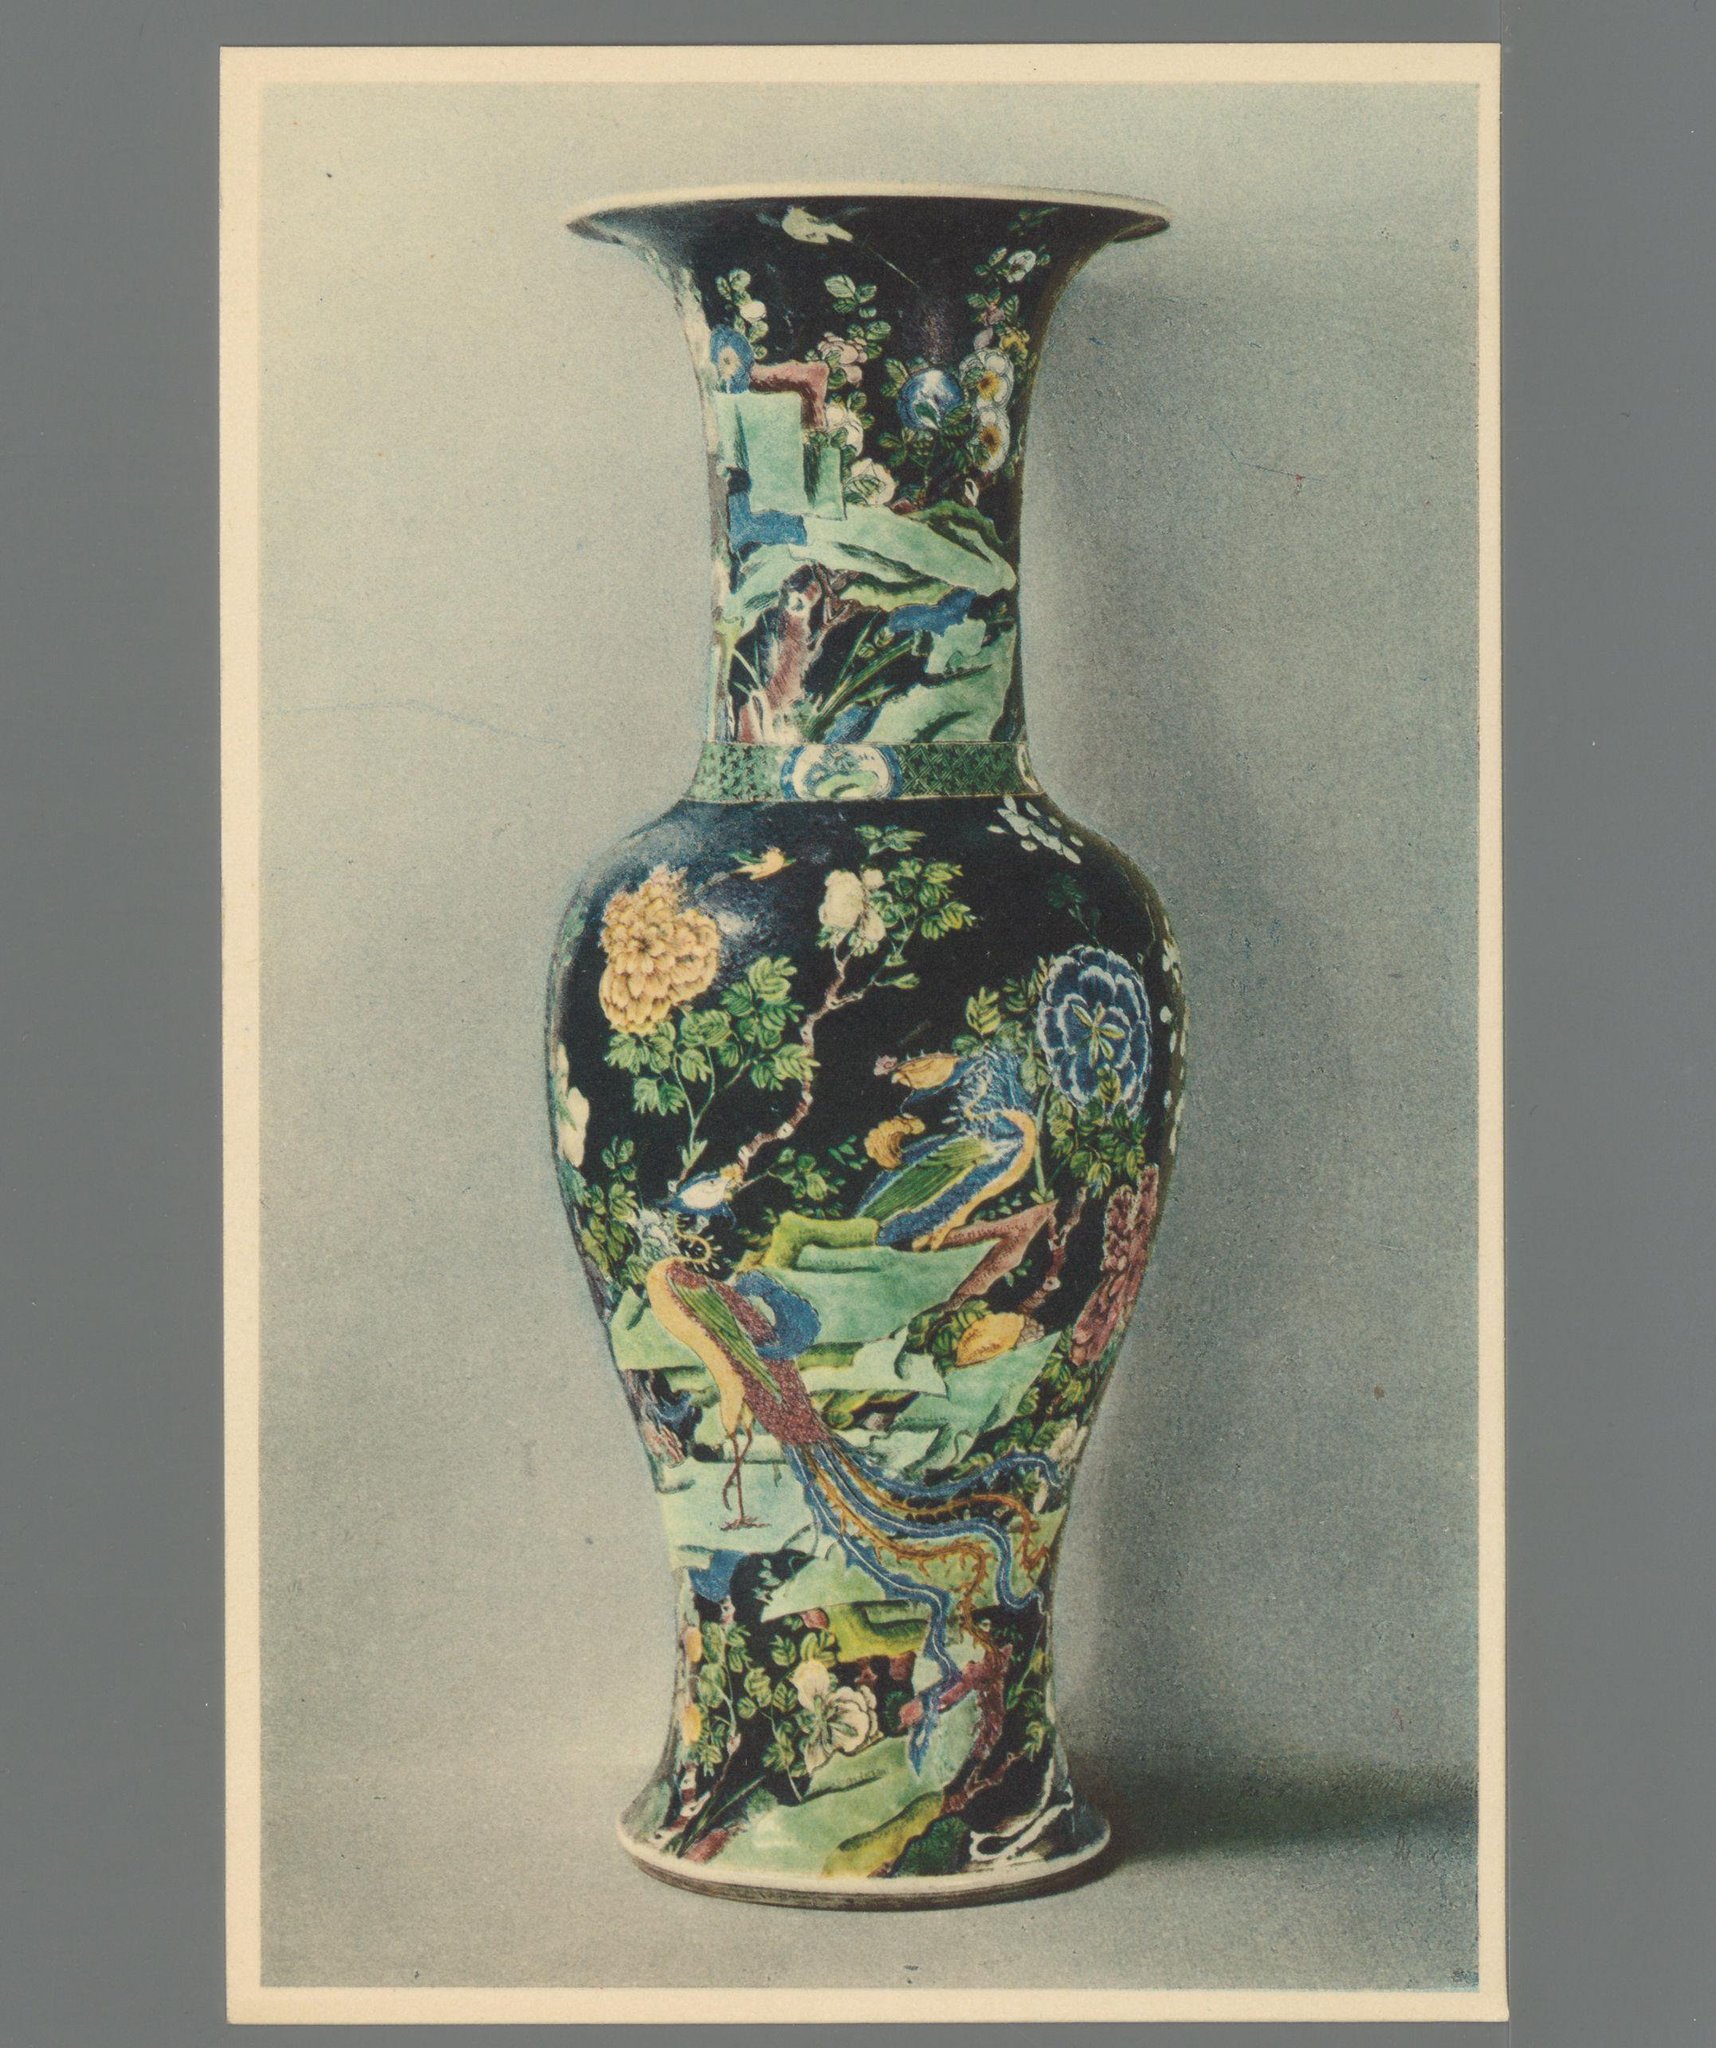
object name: photomechanical print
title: Black Hawthorn Vase, Chinese Porcelain, K'ang-hsi Period, 1662 - 1722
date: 1914-1940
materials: cardboard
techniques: photograph, lithograph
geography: vienna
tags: flowers, container of ceramics: jar, jug, pot, vase